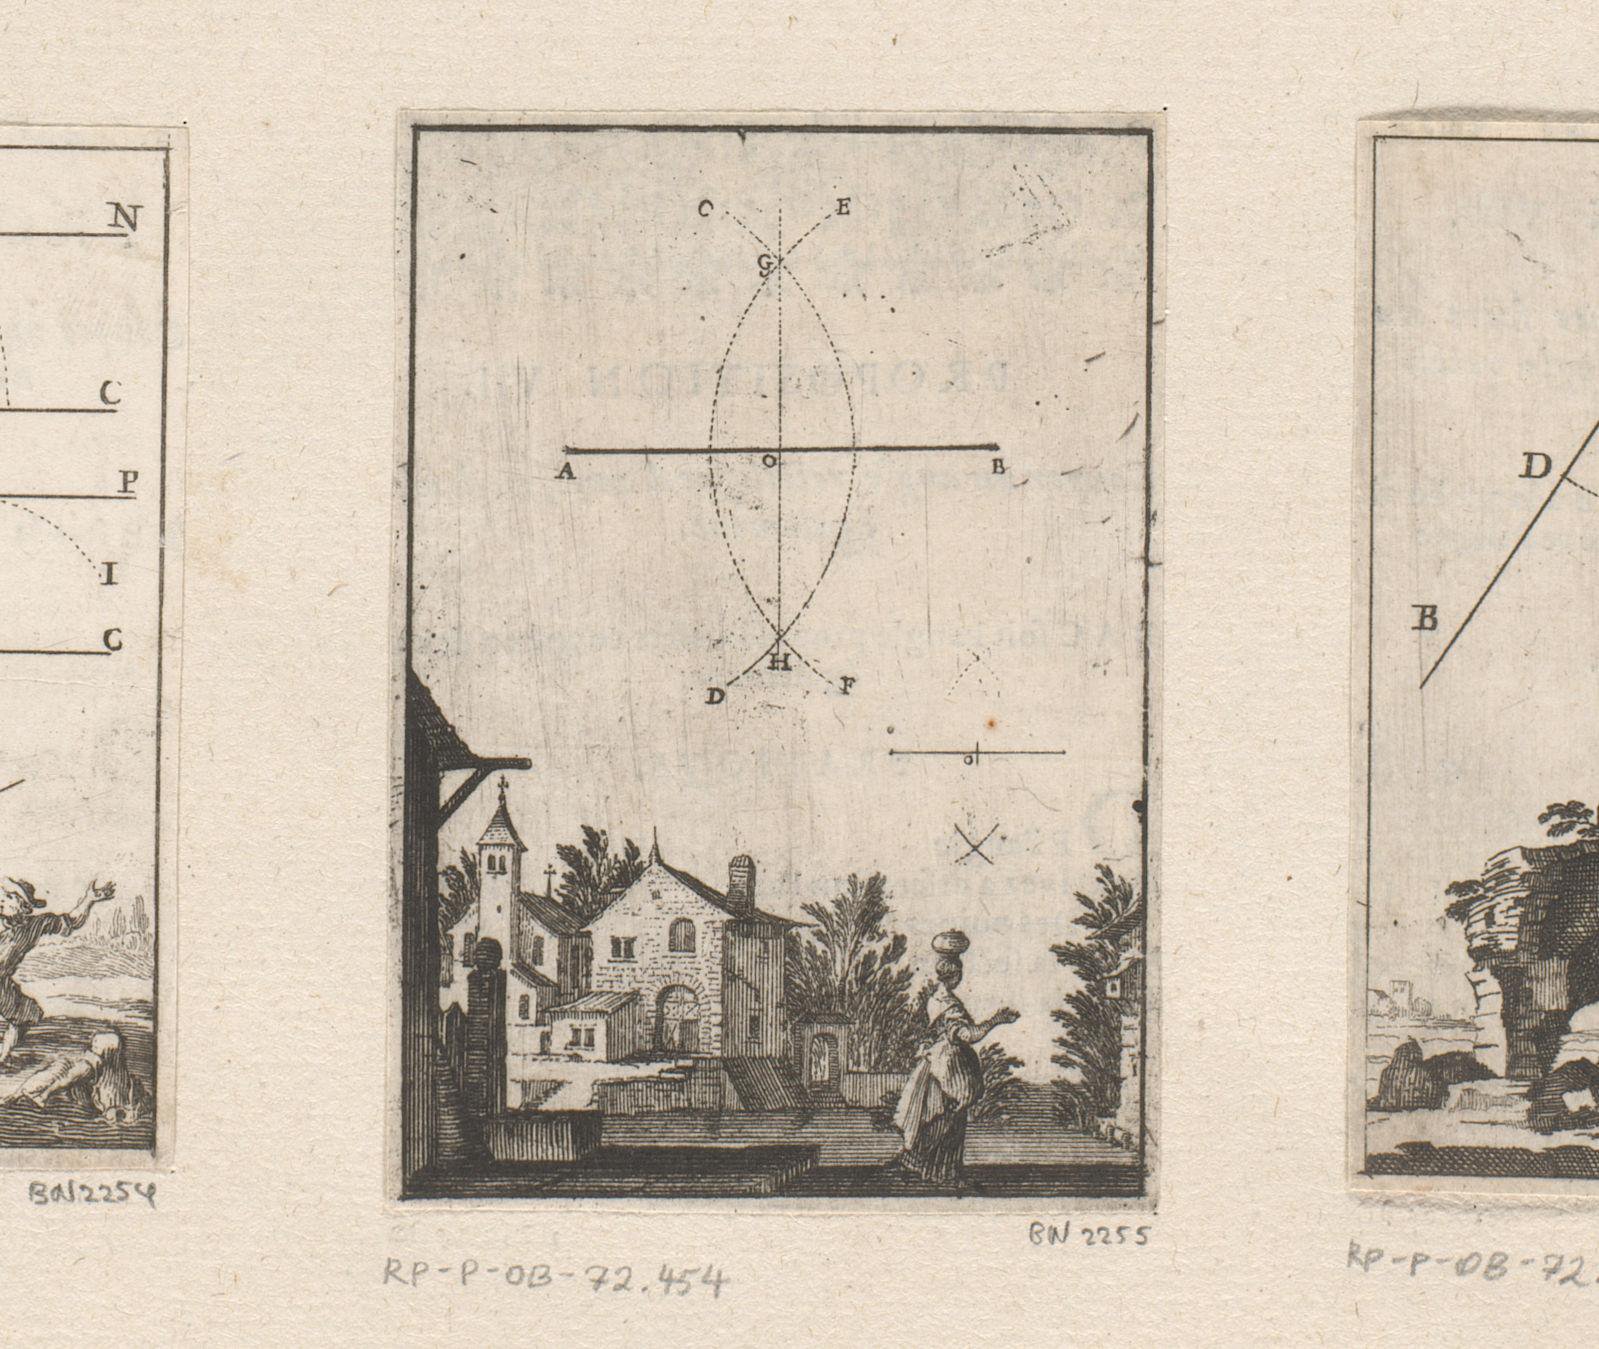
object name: book illustration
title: Delen van een rechte gegeven lijn met onderaan een dorpsgezicht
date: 1669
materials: paper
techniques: etching, letterpress printing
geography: paris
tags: city-view, and landscape with man-made constructions, adult woman, planimetry, geometry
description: Prent uit: Pratique de la géometrie, sur le papier et sur le terrain. Avec un nouvel ordre et une méthode particulière. Parijs: Thomas Jolly, 1669.